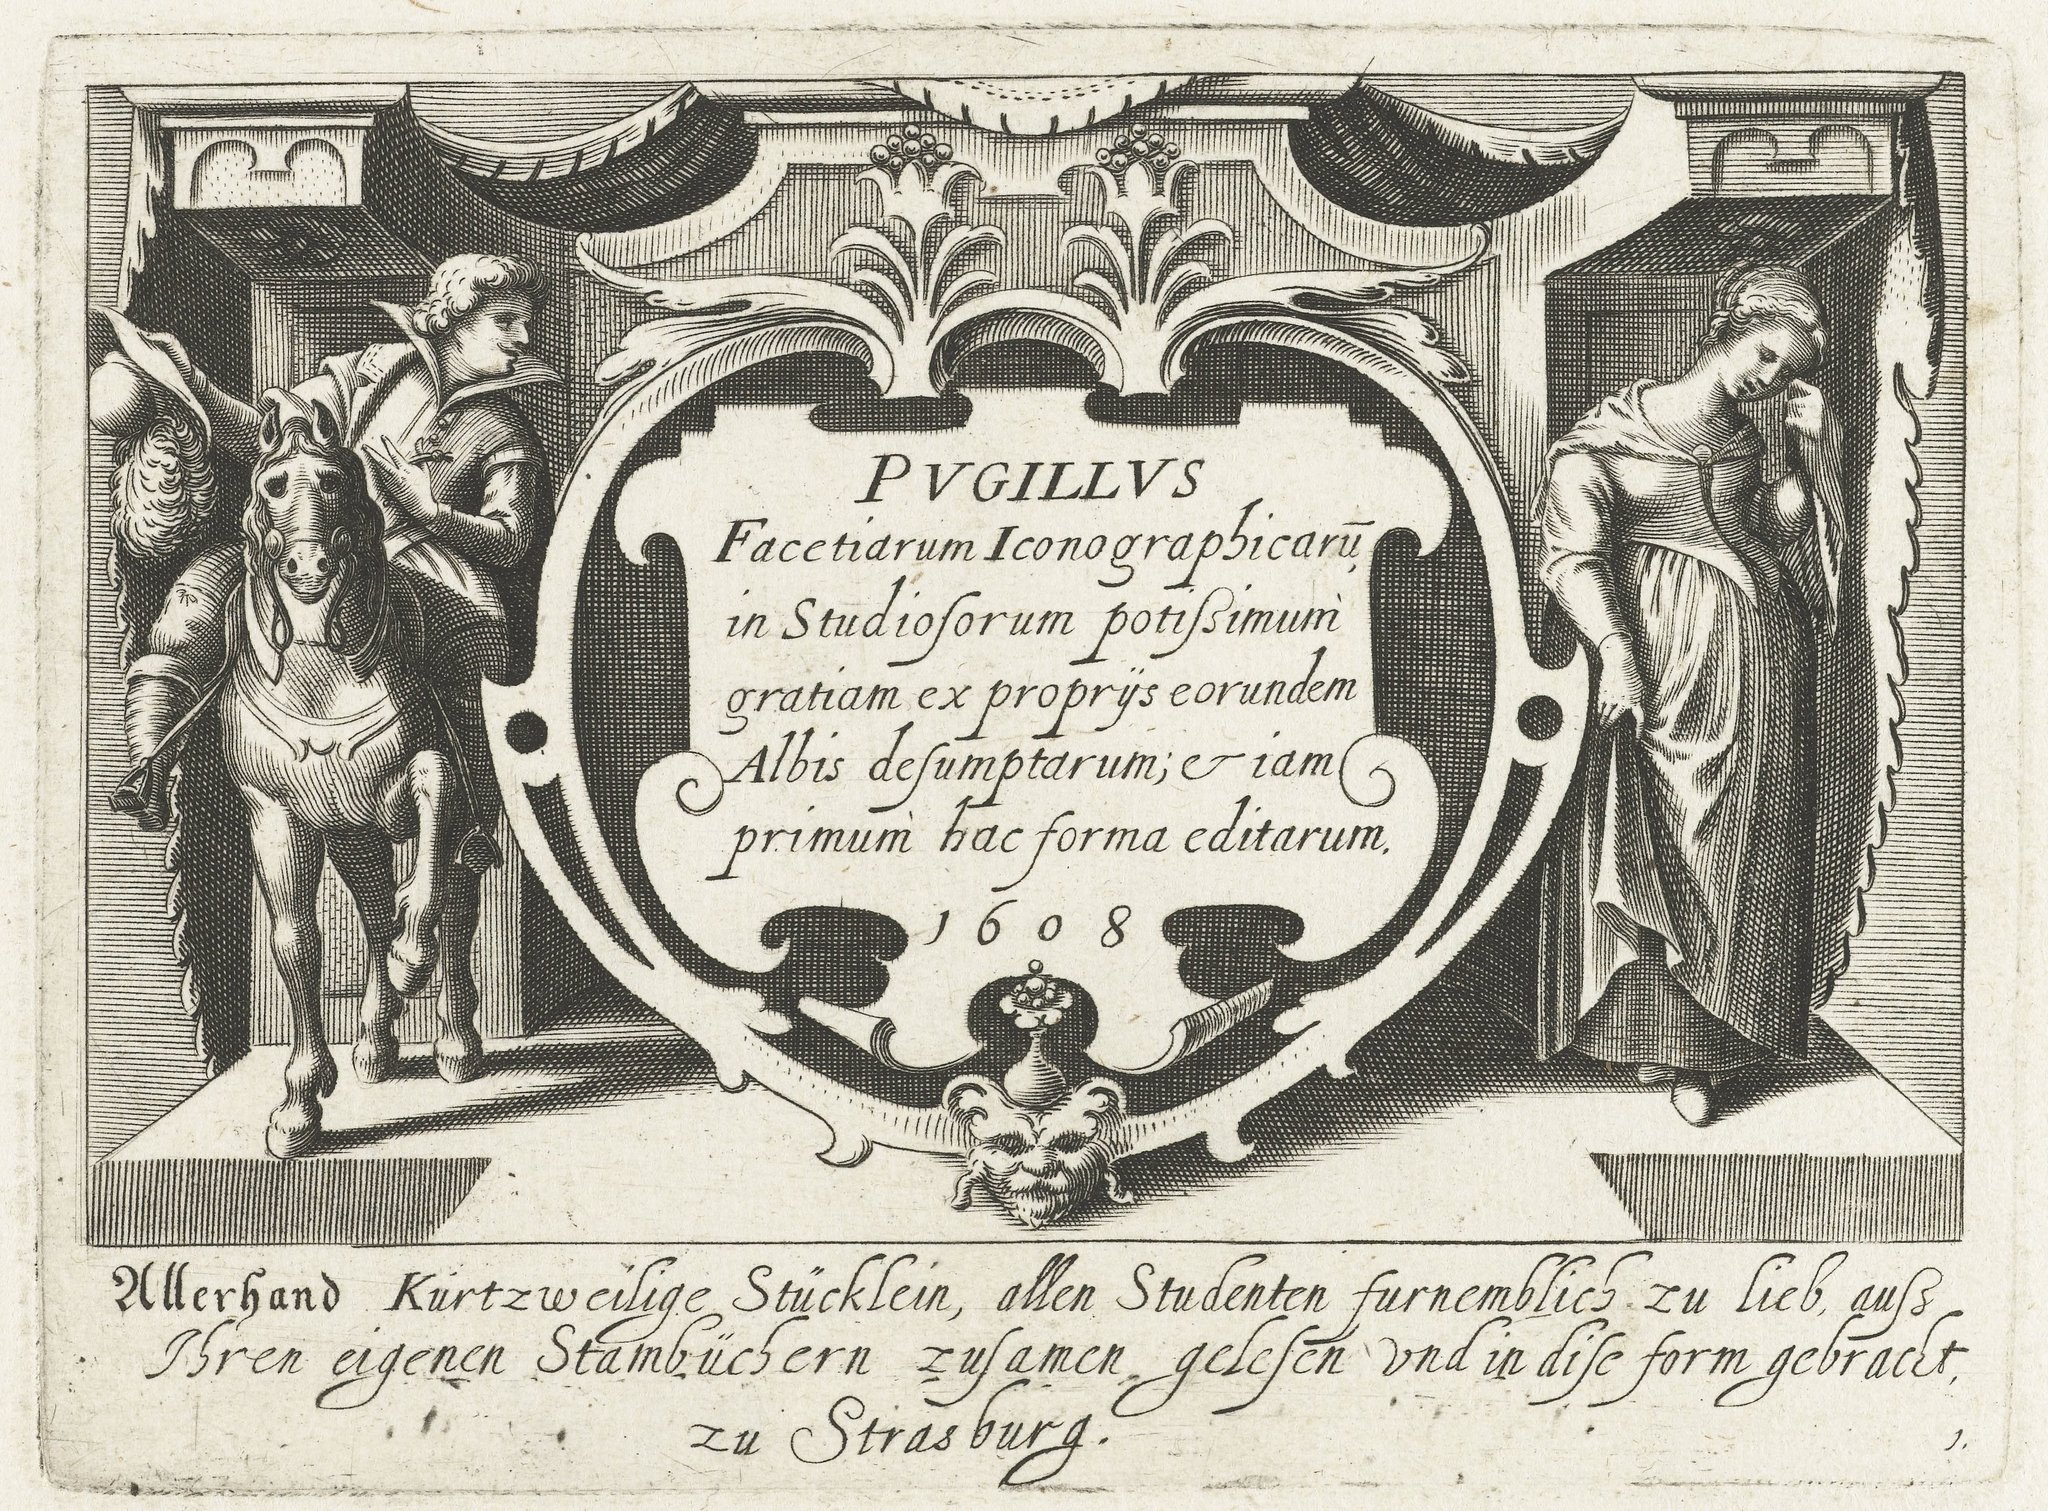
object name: titelprent, frontispice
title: Pugillus facetiarum iconographicarum in studiosorum (...)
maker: jacob van der heyden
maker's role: draughtsman, print maker, publisher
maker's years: 1573-1645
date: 1608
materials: paper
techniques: engraving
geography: straatsburg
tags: riding a horse, ass, or mule; rider, horseman, 'album amicorum', 'stammbuch', ornament ~ cartouche, weeping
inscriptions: date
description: Deze serie, getiteld ‘Pugillus facetiarum iconographicarum in studiosorum (…)’, bestond vermoedelijk uit 36 of meer prenten. Van deze serie zijn in ieder geval twee uitgaven bekend, uit 1608 en 1618. De prenten uit deze serie in de collectie van het Rijksmuseum (RP-P-1996-1 t/m RP-P-1996-36) zijn vermoedelijk afkomstig uit verschillende uitgaven, of uit de tweede uitgave. De inhoud van beide uitgaven verschilt, maar om de precieze inhoud van de verschillende uitgaven vast te stellen is meer onderzoek nodig. Er zijn geen volledige exemplaren van de eerste uitgave bekend. Aan de hand van de analyse van een andere serie, ‘Jeucht spieghel’,* die kopieën van ‘Pugillus’ bevat en is uitgegeven in 1610 én de aanwezige exemplaren van prenten uit ‘Pugillus’ in een inmiddels verloren album amicorum uit 1610,** kan in ieder geval van een aantal prenten gesteld worden dat ze al voorkwamen in de uitgave van 1608. Dit geldt voor RP-P-1996-1 (de titelprent), RP-P-1996-5, RP-P-1996-6, RP-P-1996-7, RP-P-1996-8, RP-P-1996-9, RP-P-1996-10, RP-P-1996-11, RP-P-1996-12, RP-P-1996-13, RP-P-1996-14, RP-P-1996-15, RP-P-1996-16, RP-P-1996-17, RP-P-1996-18, RP-P-1996-19, RP-P-1996-24, RP-P-1996-28, RP-P-1996-29, RP-P-1996-33 en RP-P-1996-35. Van één prent (RP-P-1996-31) kan vastgesteld worden dat die pas in de latere uitgave van 1618 voorkwam, omdat het kopie is van een prent uit weer een andere serie, ‘Academia sive speculum vitae scholasticae (…)’, die werd uitgegeven in 1612.*** De huidige prent is de titelprent van de uitgave van 1608. * Z.G.H.P.H.S [Zacharias Heyns]. Jeucht spieghel. S.l.s.n., 1610. Voor een gedigitaliseerd exemplaar zie: https://archive.org/details/ned-kbn-all-00000628-001/page/n9/mode/2up. ** Zie: Erman, Wilhelm en Ewald Horn. Bibliographie der deutschen Universitäten, systematisch geordnetes Verzeichnis der bis Ende 1899 gedruckten Bücher und Aufsätze über das deutsche Universitätswesen. Leipzig en Berlijn: Verlag von B.G. Teubner, 1904, dl. 1, p. 826-832, no. 17328. https://archive.org/details/bibliographieder01ermauoft/page/826/mode/2up *** Passe, Crispijn van de (I). Academia sive speculum vitae scholasticae (…). Arnhem: Johannes Janssonius [Jan Jansz.], 1612. Voor een gedigitaliseerd exemplaar zie: http://gallica.bnf.fr/ark:/12148/btv1b55005974h.